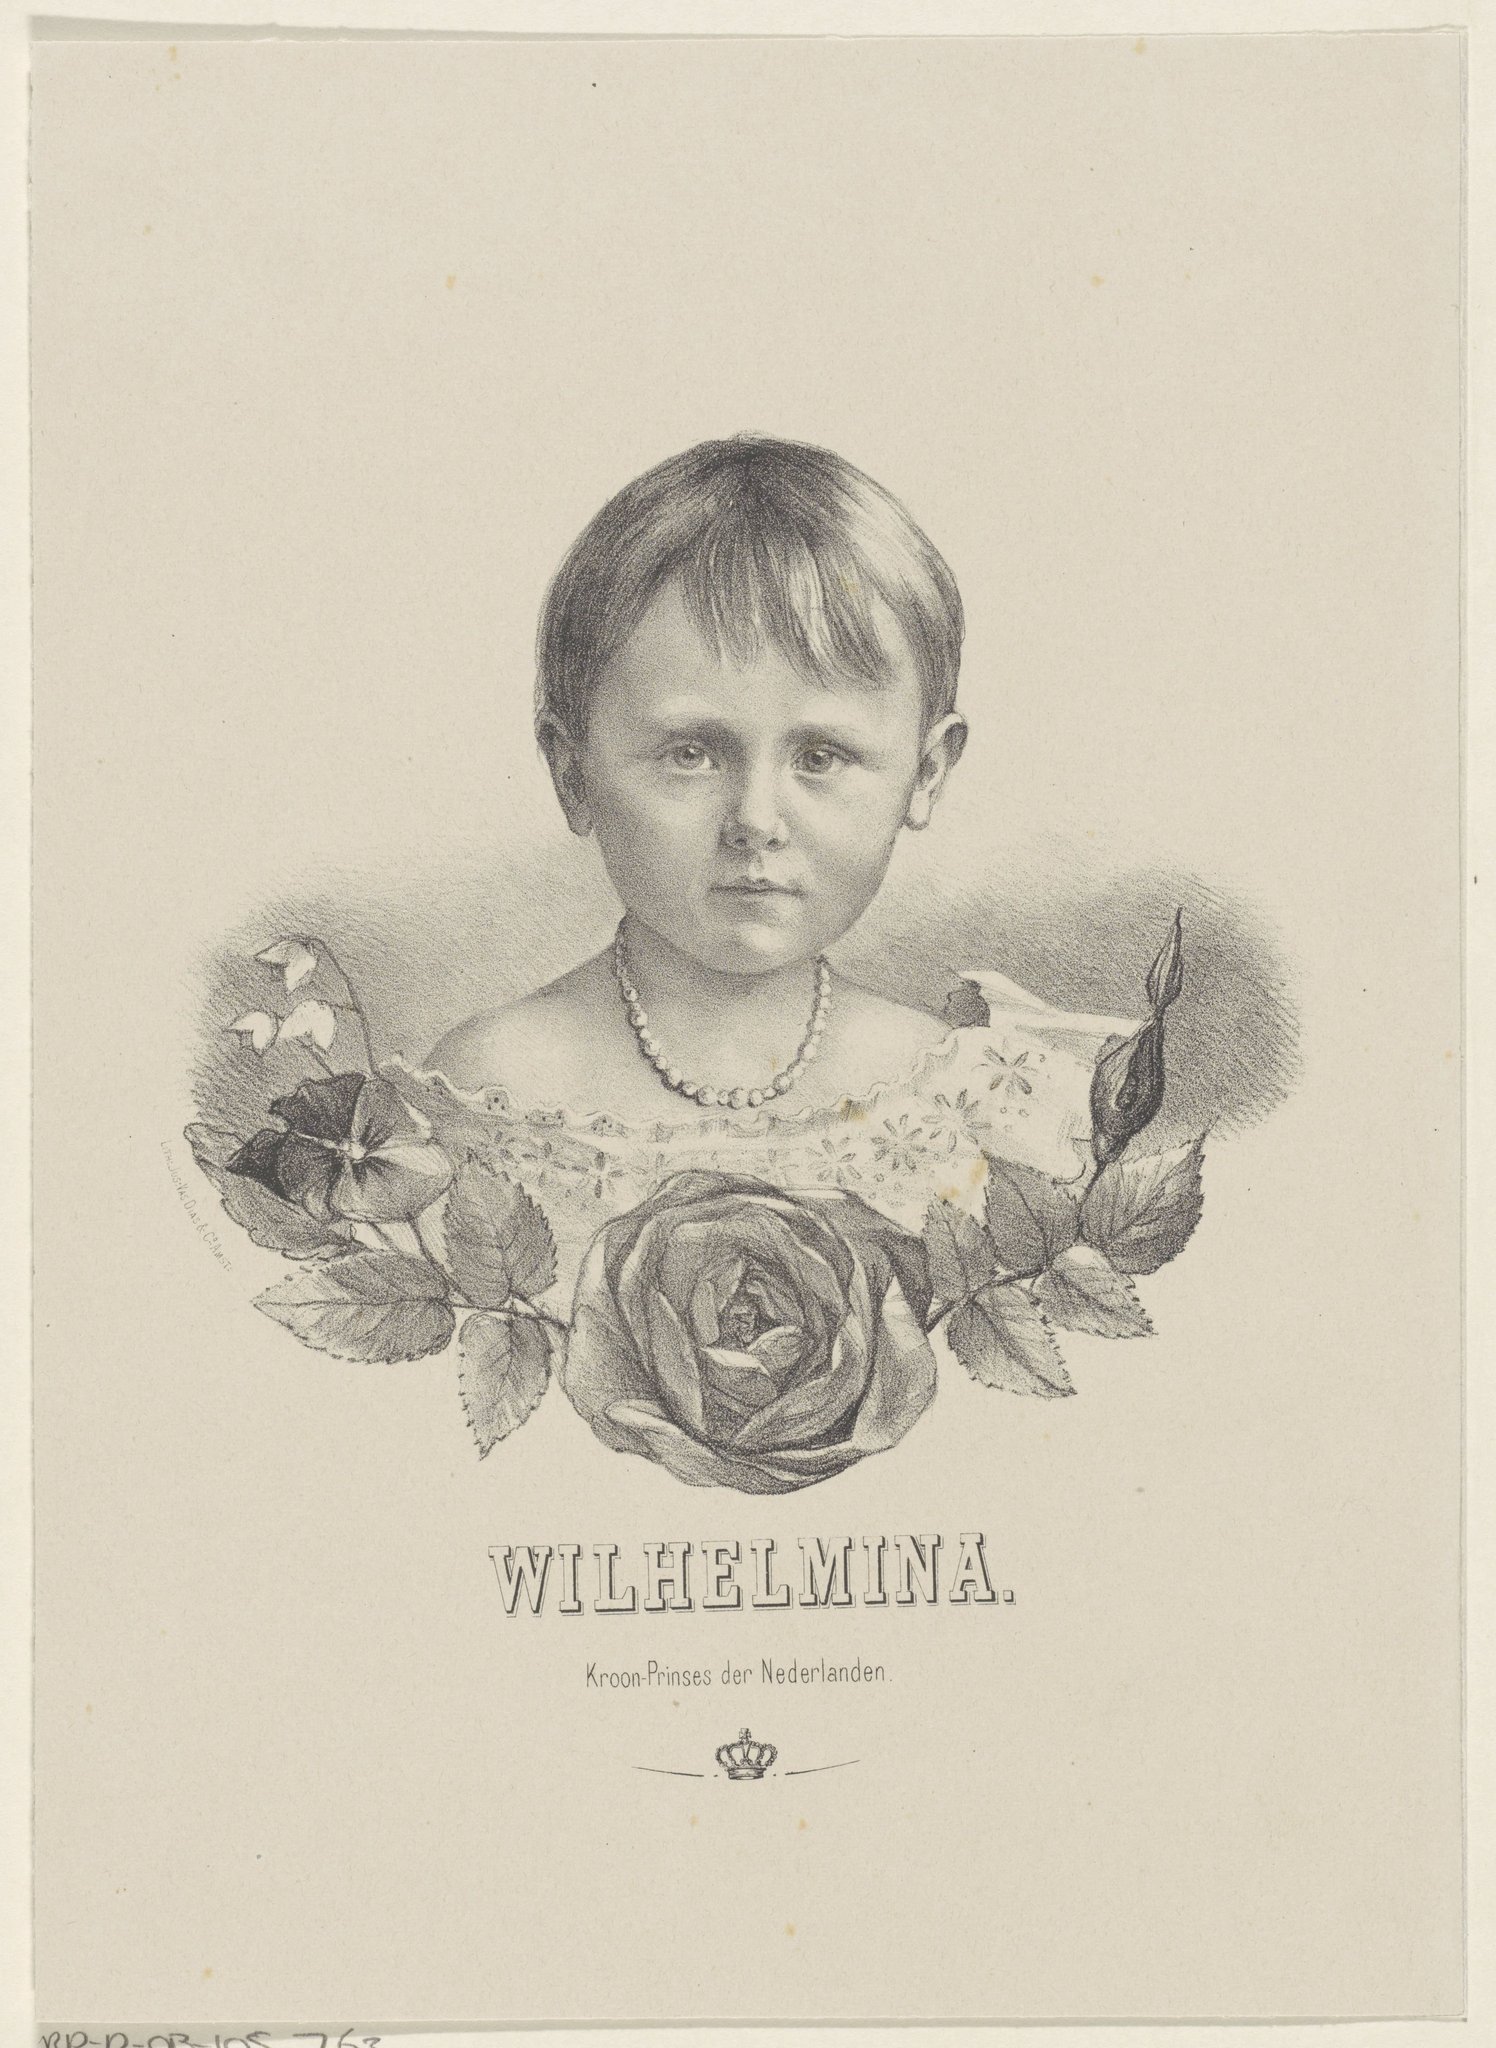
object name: print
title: Portret van Wilhelmina, koningin der Nederlanden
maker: Anonymous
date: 1882-1949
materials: paper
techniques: lithograph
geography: netherlands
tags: the hague, print maker, wilhelmina of the netherlands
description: De hier vermelde titel verwijst naar de hoogst verkregen titel van de geportretteerde, niet per se naar de titel die de geportretteerde op deze voorstelling draagt.